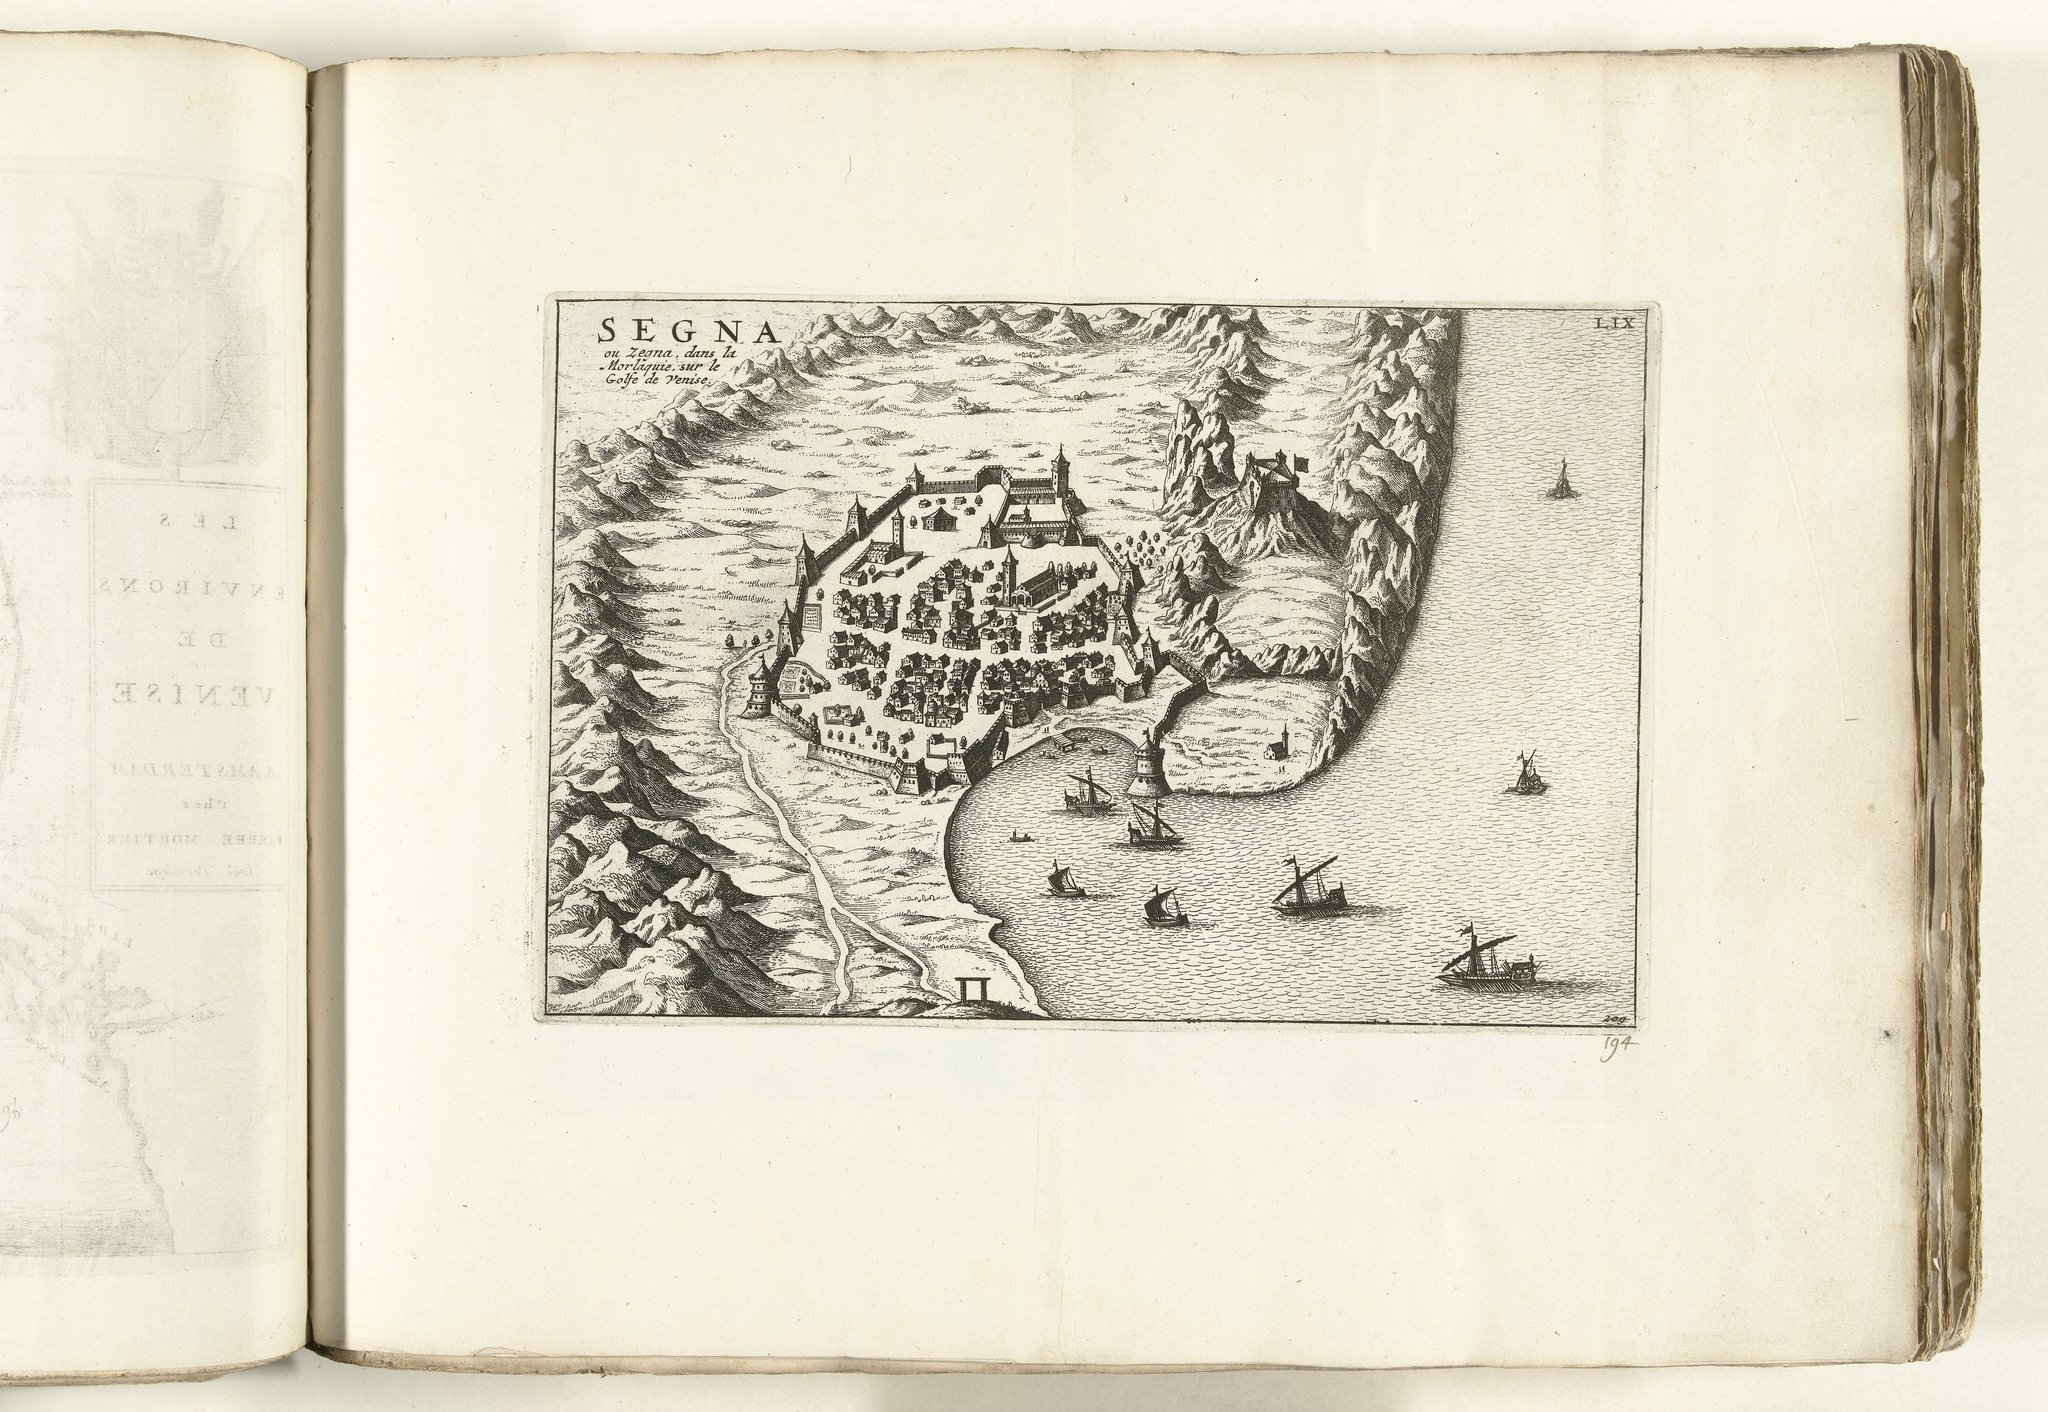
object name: map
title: Gezicht op Senj, ca. 1702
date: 1702-1703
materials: paper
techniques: etching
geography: amsterdam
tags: senj, spaanse successieoorlog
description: Gezicht op de Kroatische kuststad Senj (Segna). Gemerkt rechtsboven: LIX. Plaat nr. 194 (was 209) in het prentwerk bestaande in totaal uit 276 genummerde platen van vermaarde sterke steden en vestingen in het kader van de Spaanse Successieoorlog. Voor het merendeel zijn deze platen gekopieerd naar de anonieme Franse platen: in Les forces de l'Europe en in: Le theatre de la guerre, dans les Pays-Bas, beide oorspronkelijk uitgegeven door Nicolas de Fer te Parijs (1693-1697) in het kader van de Negenjarige Oorlog. Titel en opschriften in de plaat in het Frans.